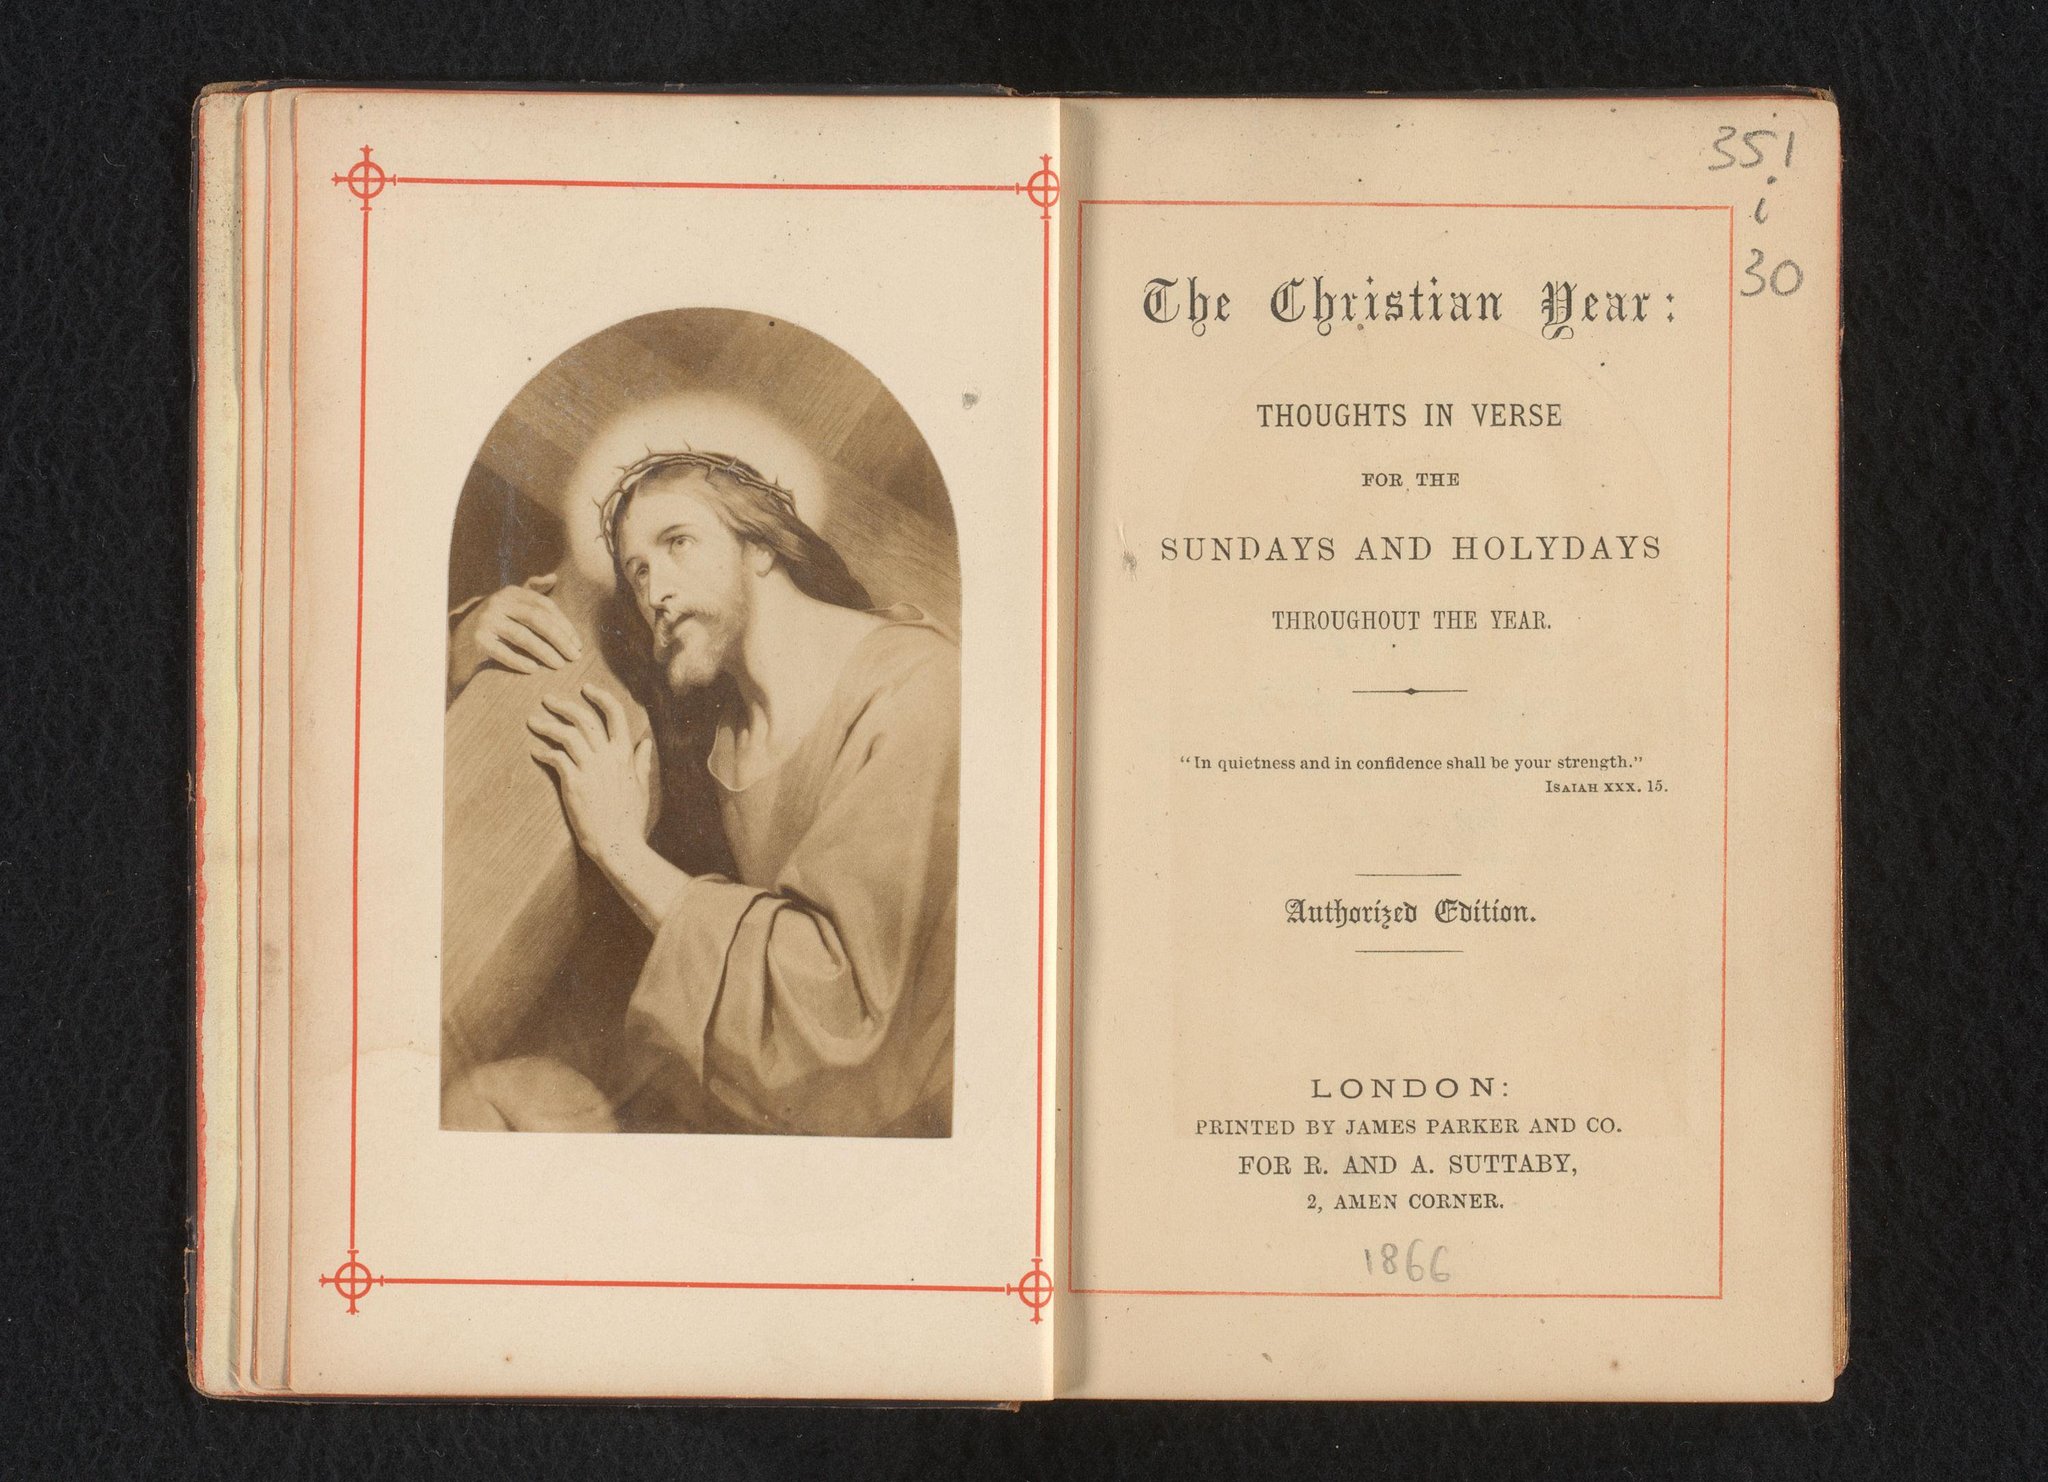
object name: reproduction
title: Fotoreproductie van een schilderij van de kruisdraging van Christus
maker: Anonymous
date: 1861-1866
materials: paper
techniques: albumen print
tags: carrying of the cross: christ bearing the cross, alone or with the help of others (e.g. simon the cyrenian)